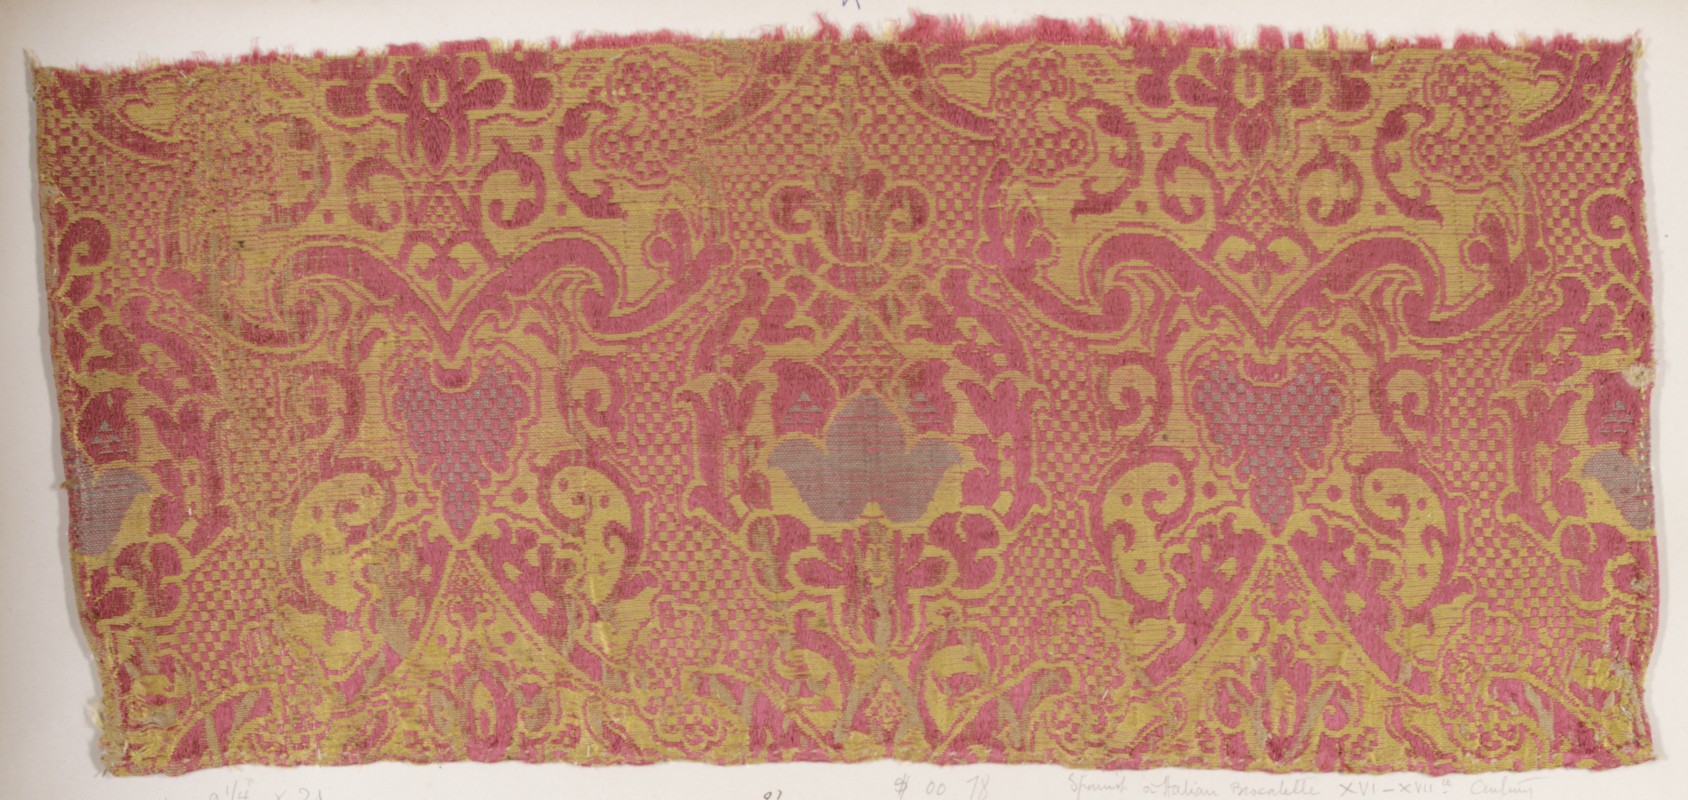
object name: fragment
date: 1501-1700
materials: silk